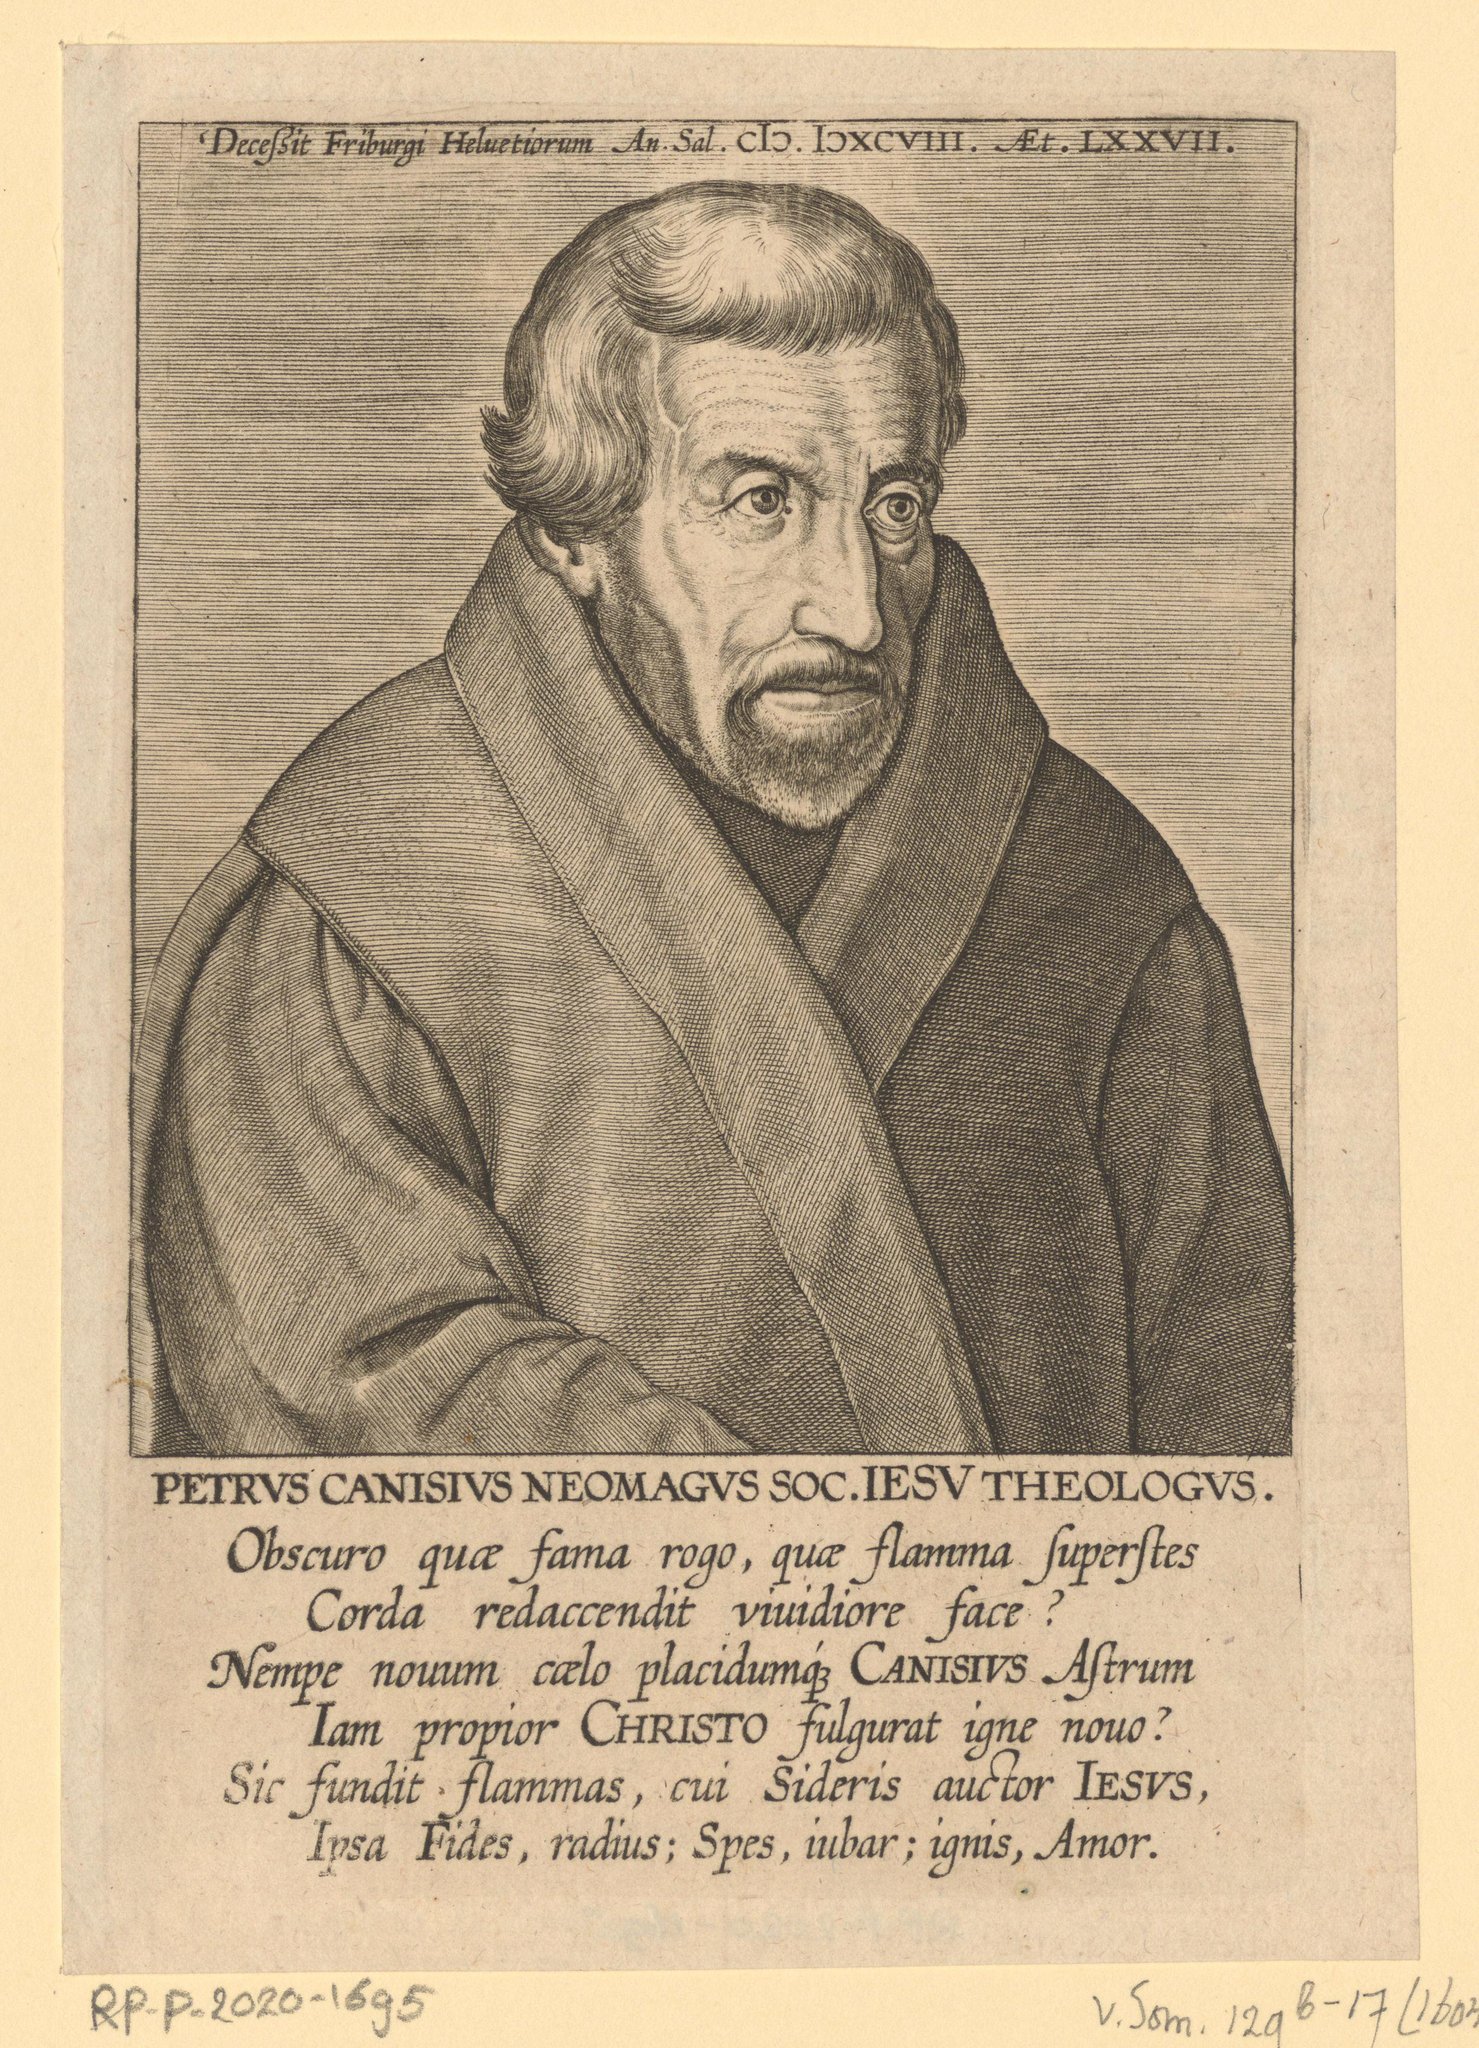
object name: print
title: Portretten van beroemde Nederlandse en Vlaamse geleerden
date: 1604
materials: paper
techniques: engraving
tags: nijmegen, historical persons